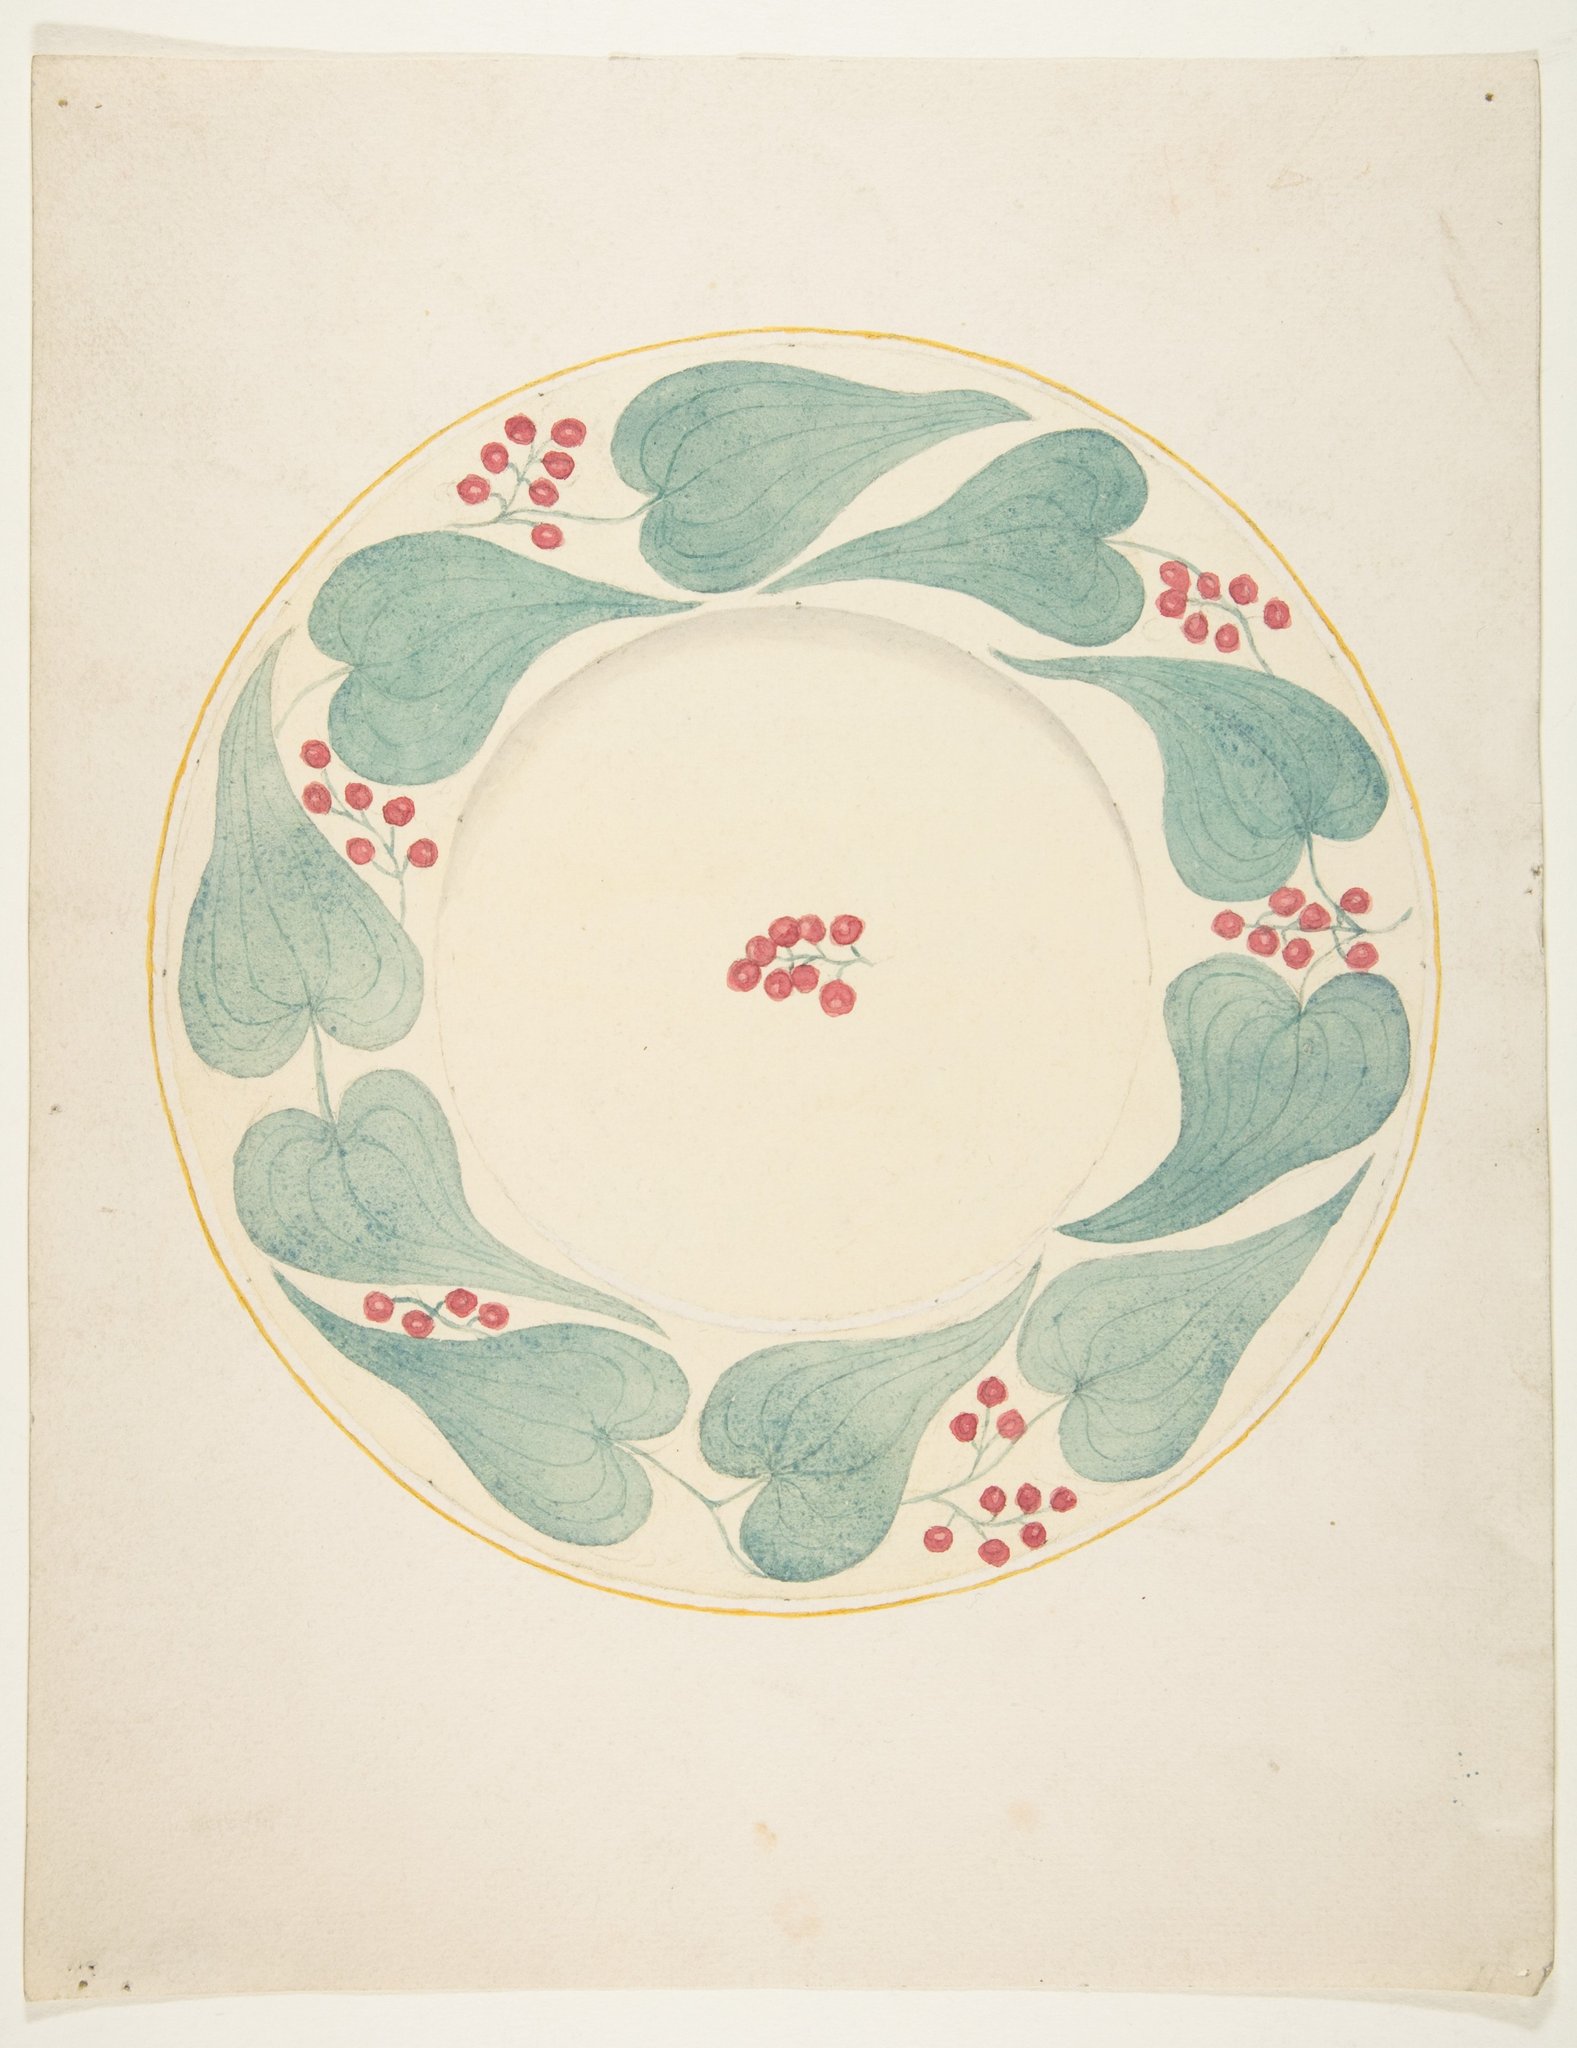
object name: drawing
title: Design for a Fruit Plate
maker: anonymous, french, 19th century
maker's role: artist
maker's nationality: french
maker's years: 1800-1900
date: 1801-1900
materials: graphite, ink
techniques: brush, heightening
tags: fruit,dishes